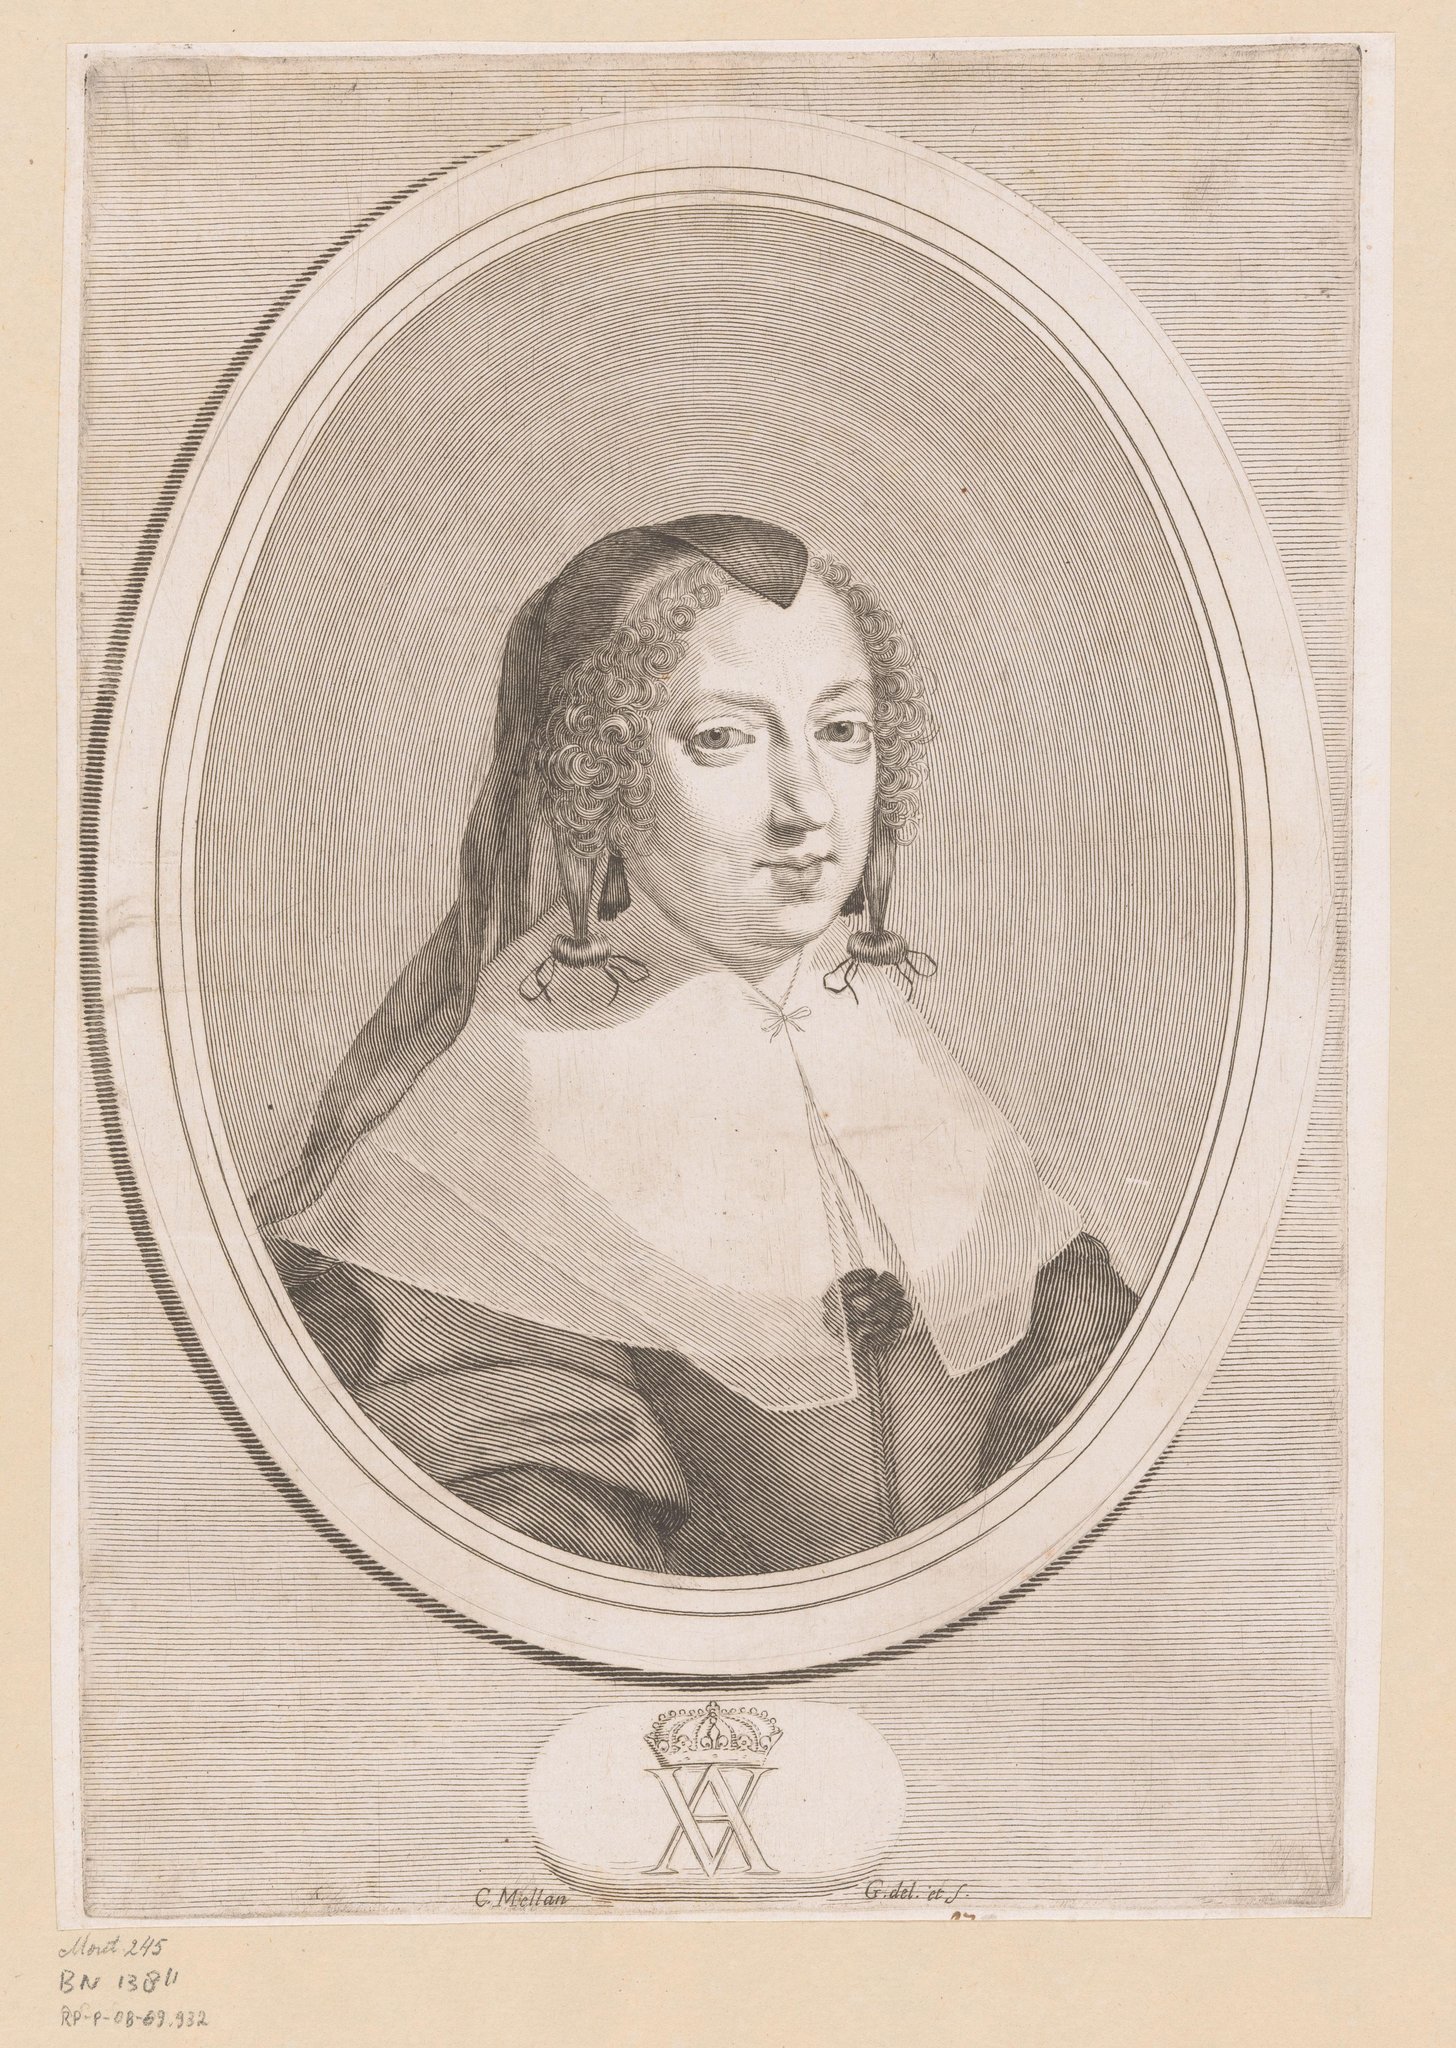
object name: print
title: Portret van Anna van Oostenrijk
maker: claude mellan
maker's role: draughtsman, print maker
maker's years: 1598-1688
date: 1644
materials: paper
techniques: engraving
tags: paris, anna van oostenrijk (koningin van frankrijk), historical persons - bb - woman, ruler, sovereign - bb - female ruler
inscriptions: watermark, collector's mark: Lugt 240